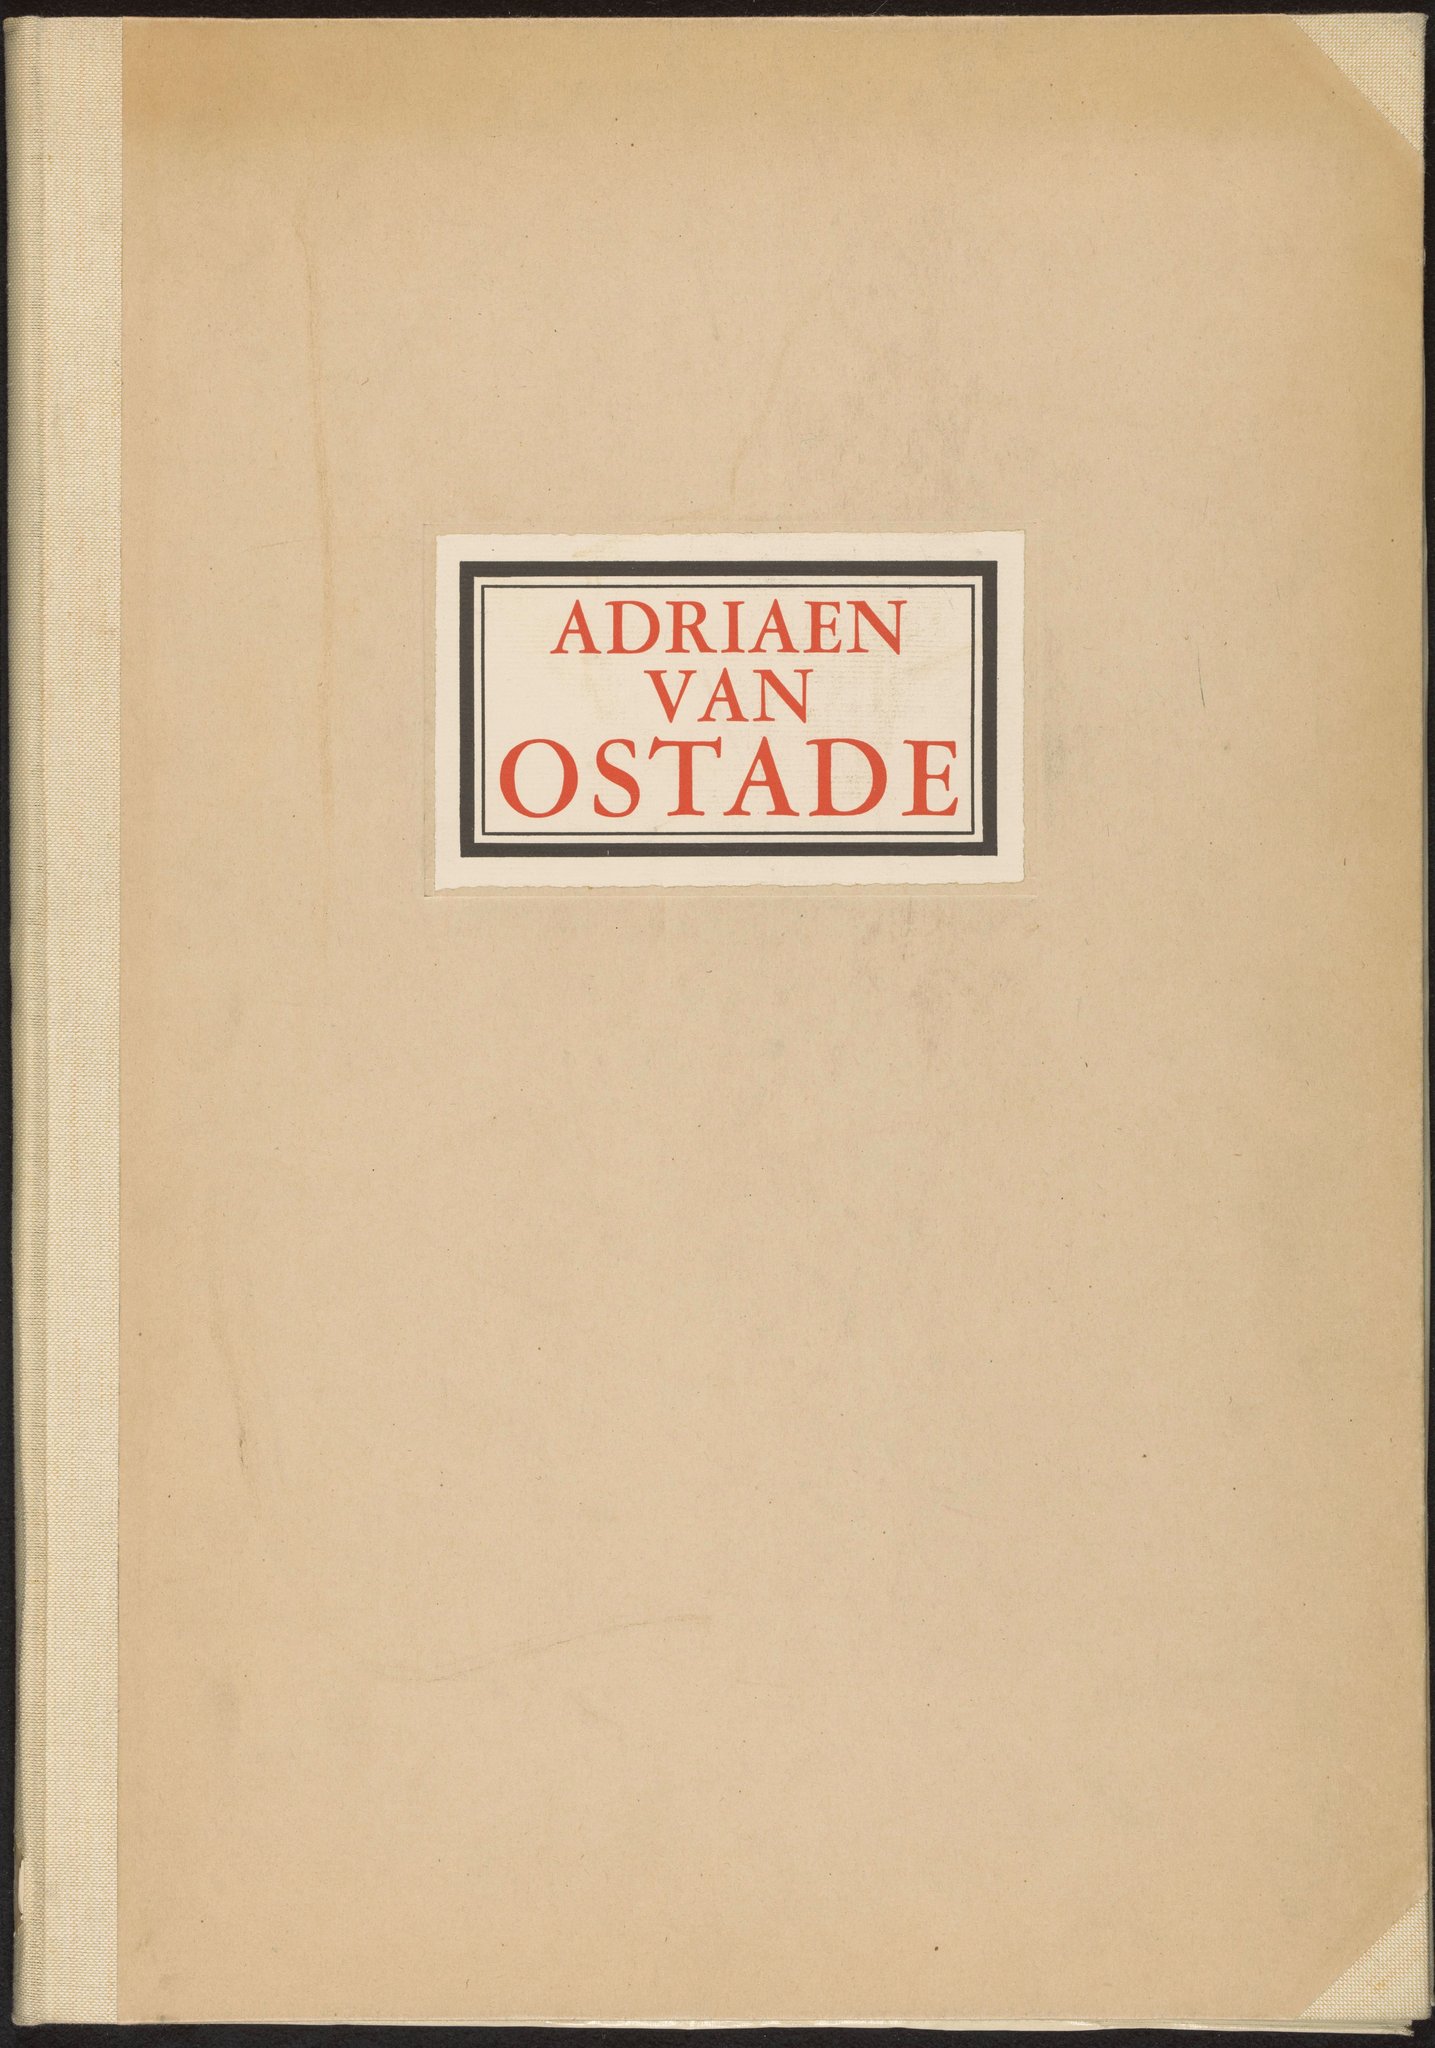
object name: prentrecueil, prentenalbum, prentalbum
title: Adriaen van Ostade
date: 1647-1679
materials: linen, paper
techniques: etching, galvanization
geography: haarlem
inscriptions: collector's mark: ‘B’, collector's mark: ‘RIJKS / MUSM’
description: Portefeuille met 50 voorstellingen op 32 albumbladen. Het betreft een moderne uitgave van het oeuvre van Adriaen van Ostade, gedrukt van de originele platen. Daarbij een inhoudsopgave en een inleiding van J.G. van Gelder. Dit is exemplaar 67 van een oplage van 70. Halflinnen portefeuille.